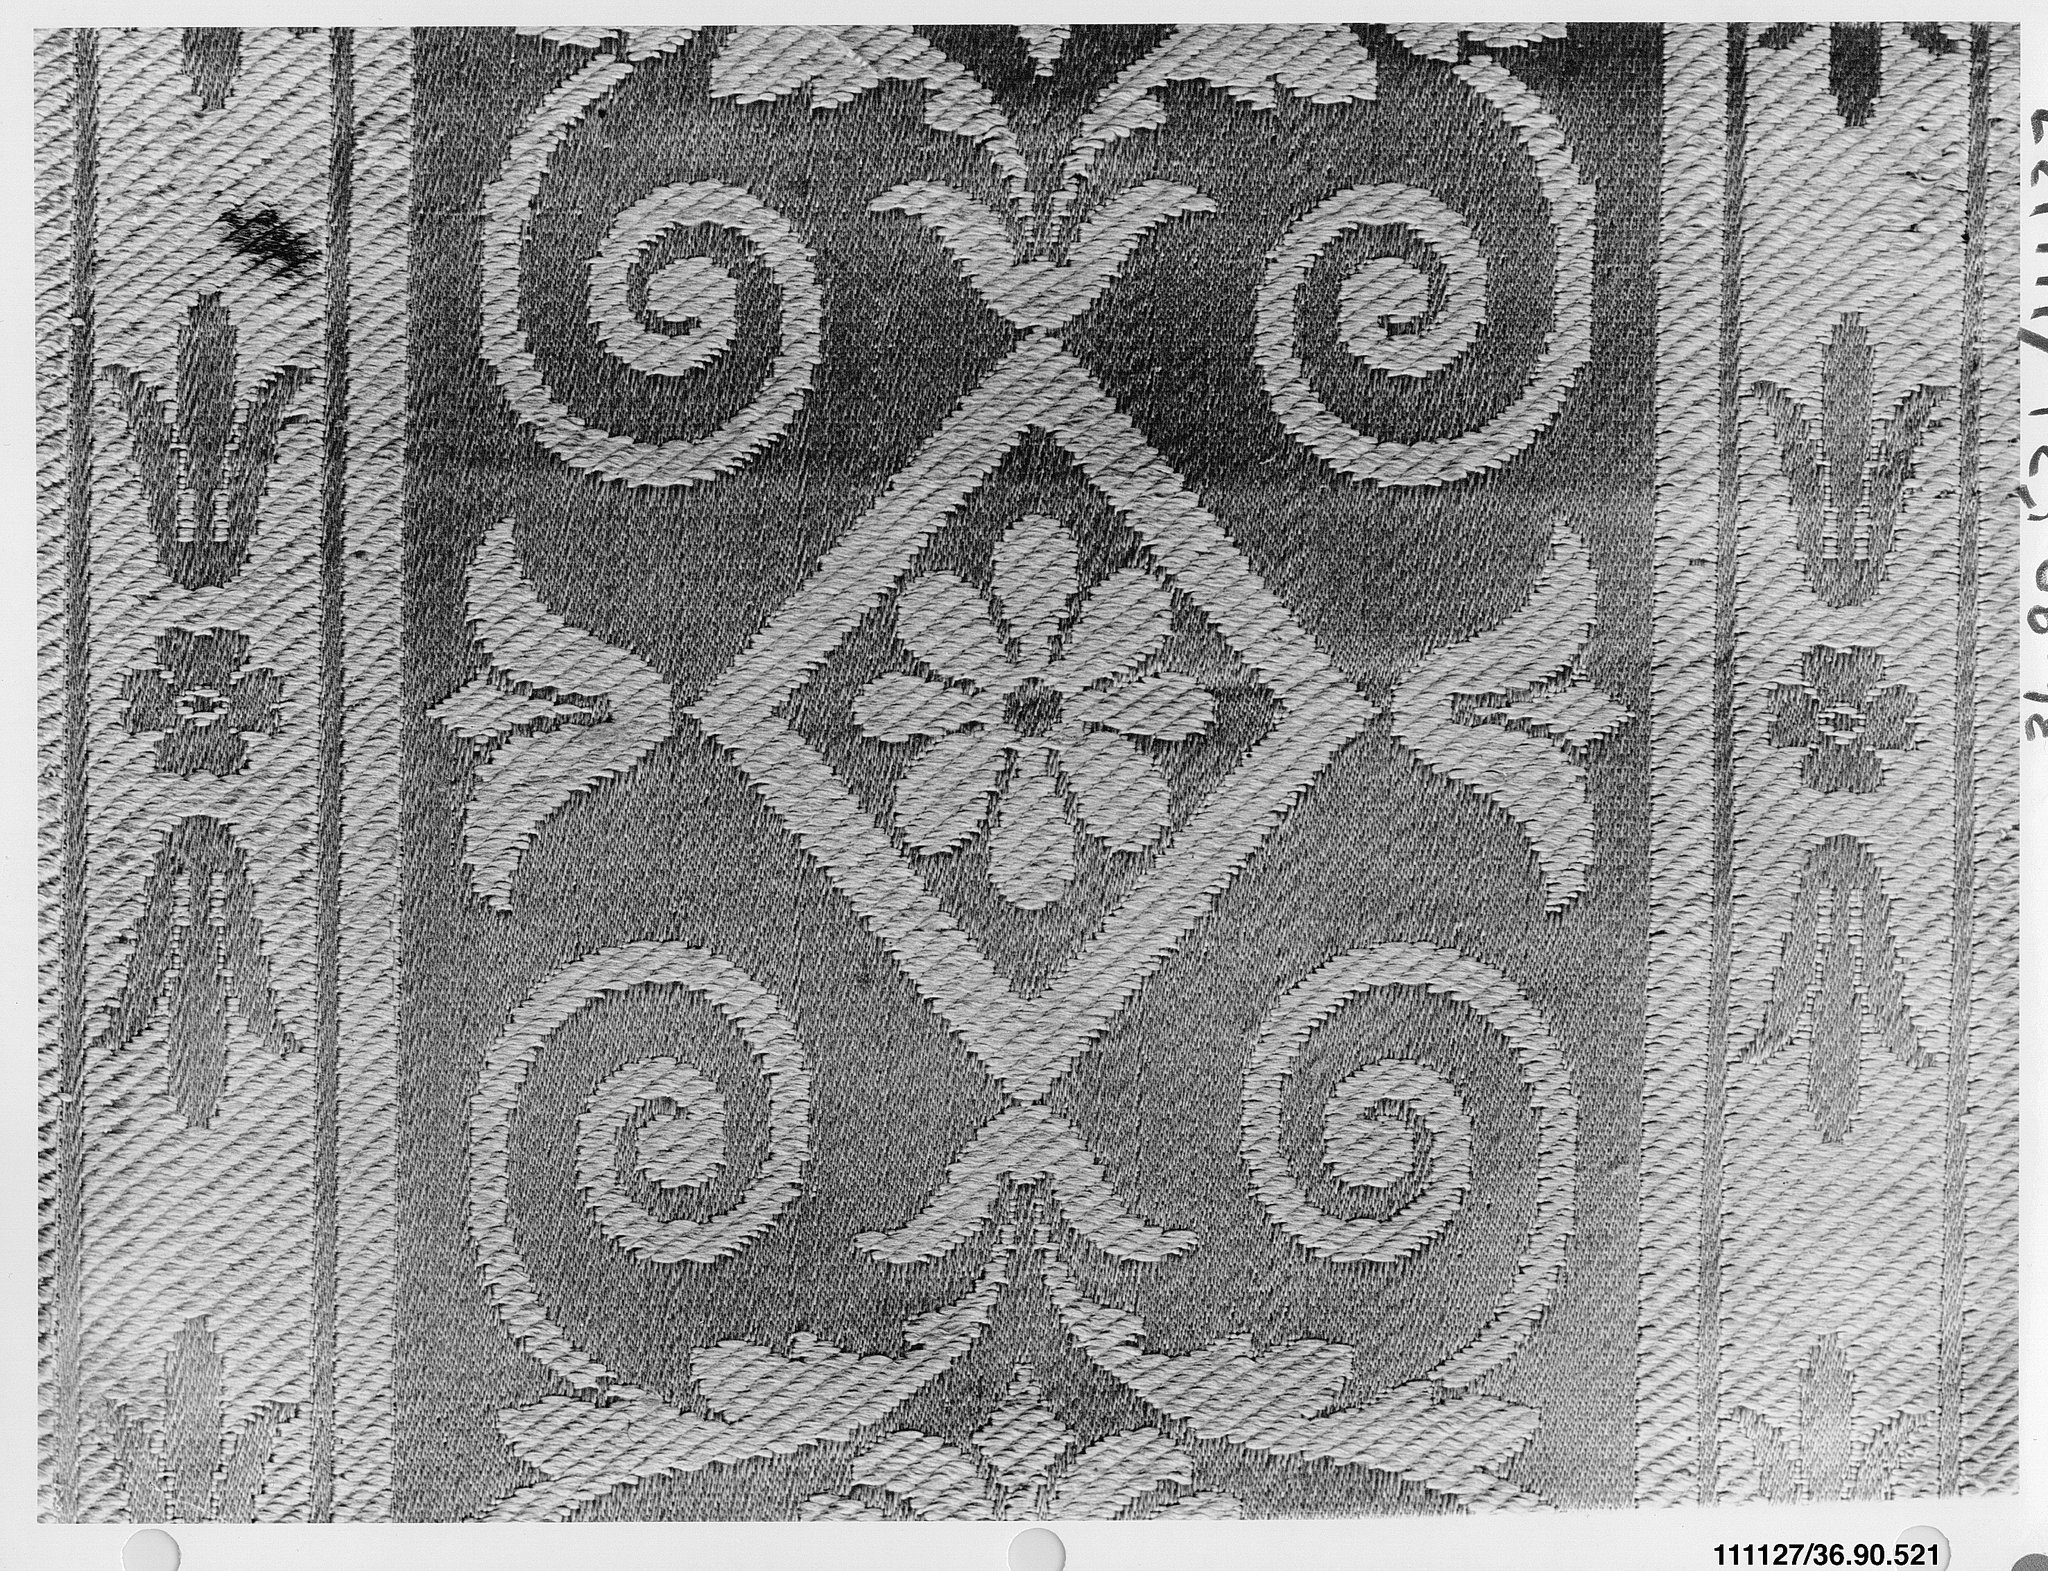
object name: piece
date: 1801-1833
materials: silk